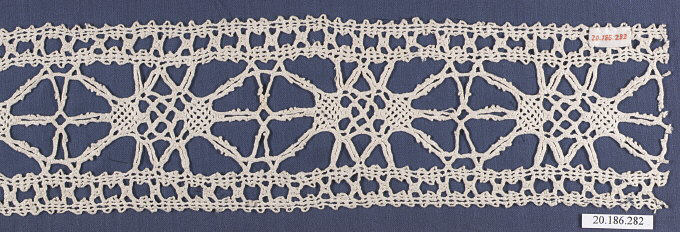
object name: insertion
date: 1501-1600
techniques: lace